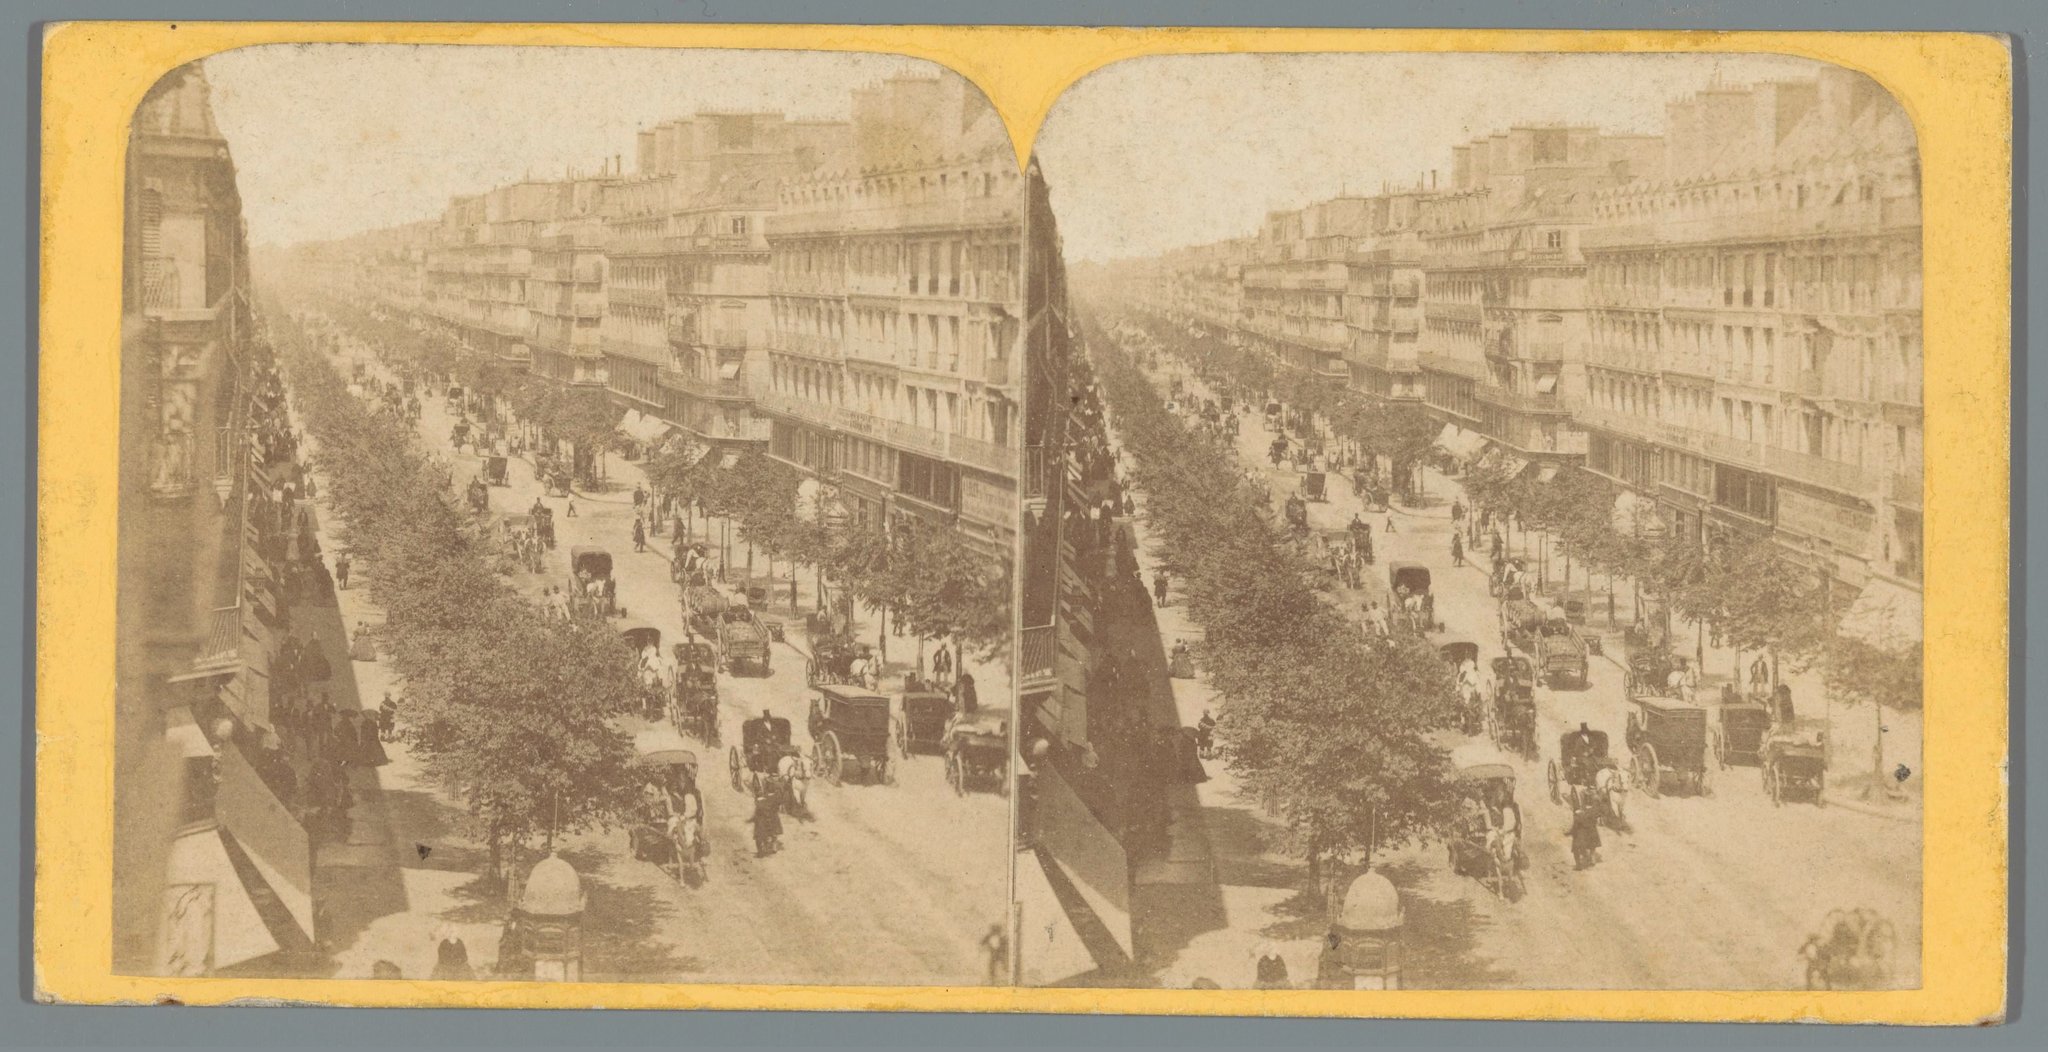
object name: stereograph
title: Vue Instantanée de Paris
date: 1850-1880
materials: cardboard, photographic support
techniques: albumen print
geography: paris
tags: animal traction, animal-drawn vehicle (carriage etc.), street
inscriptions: number: ‘No. 52’, inscription: ‘1862 (no 145 van zelfde serie is foto van fête industrielle du 25 janvier 1863)’